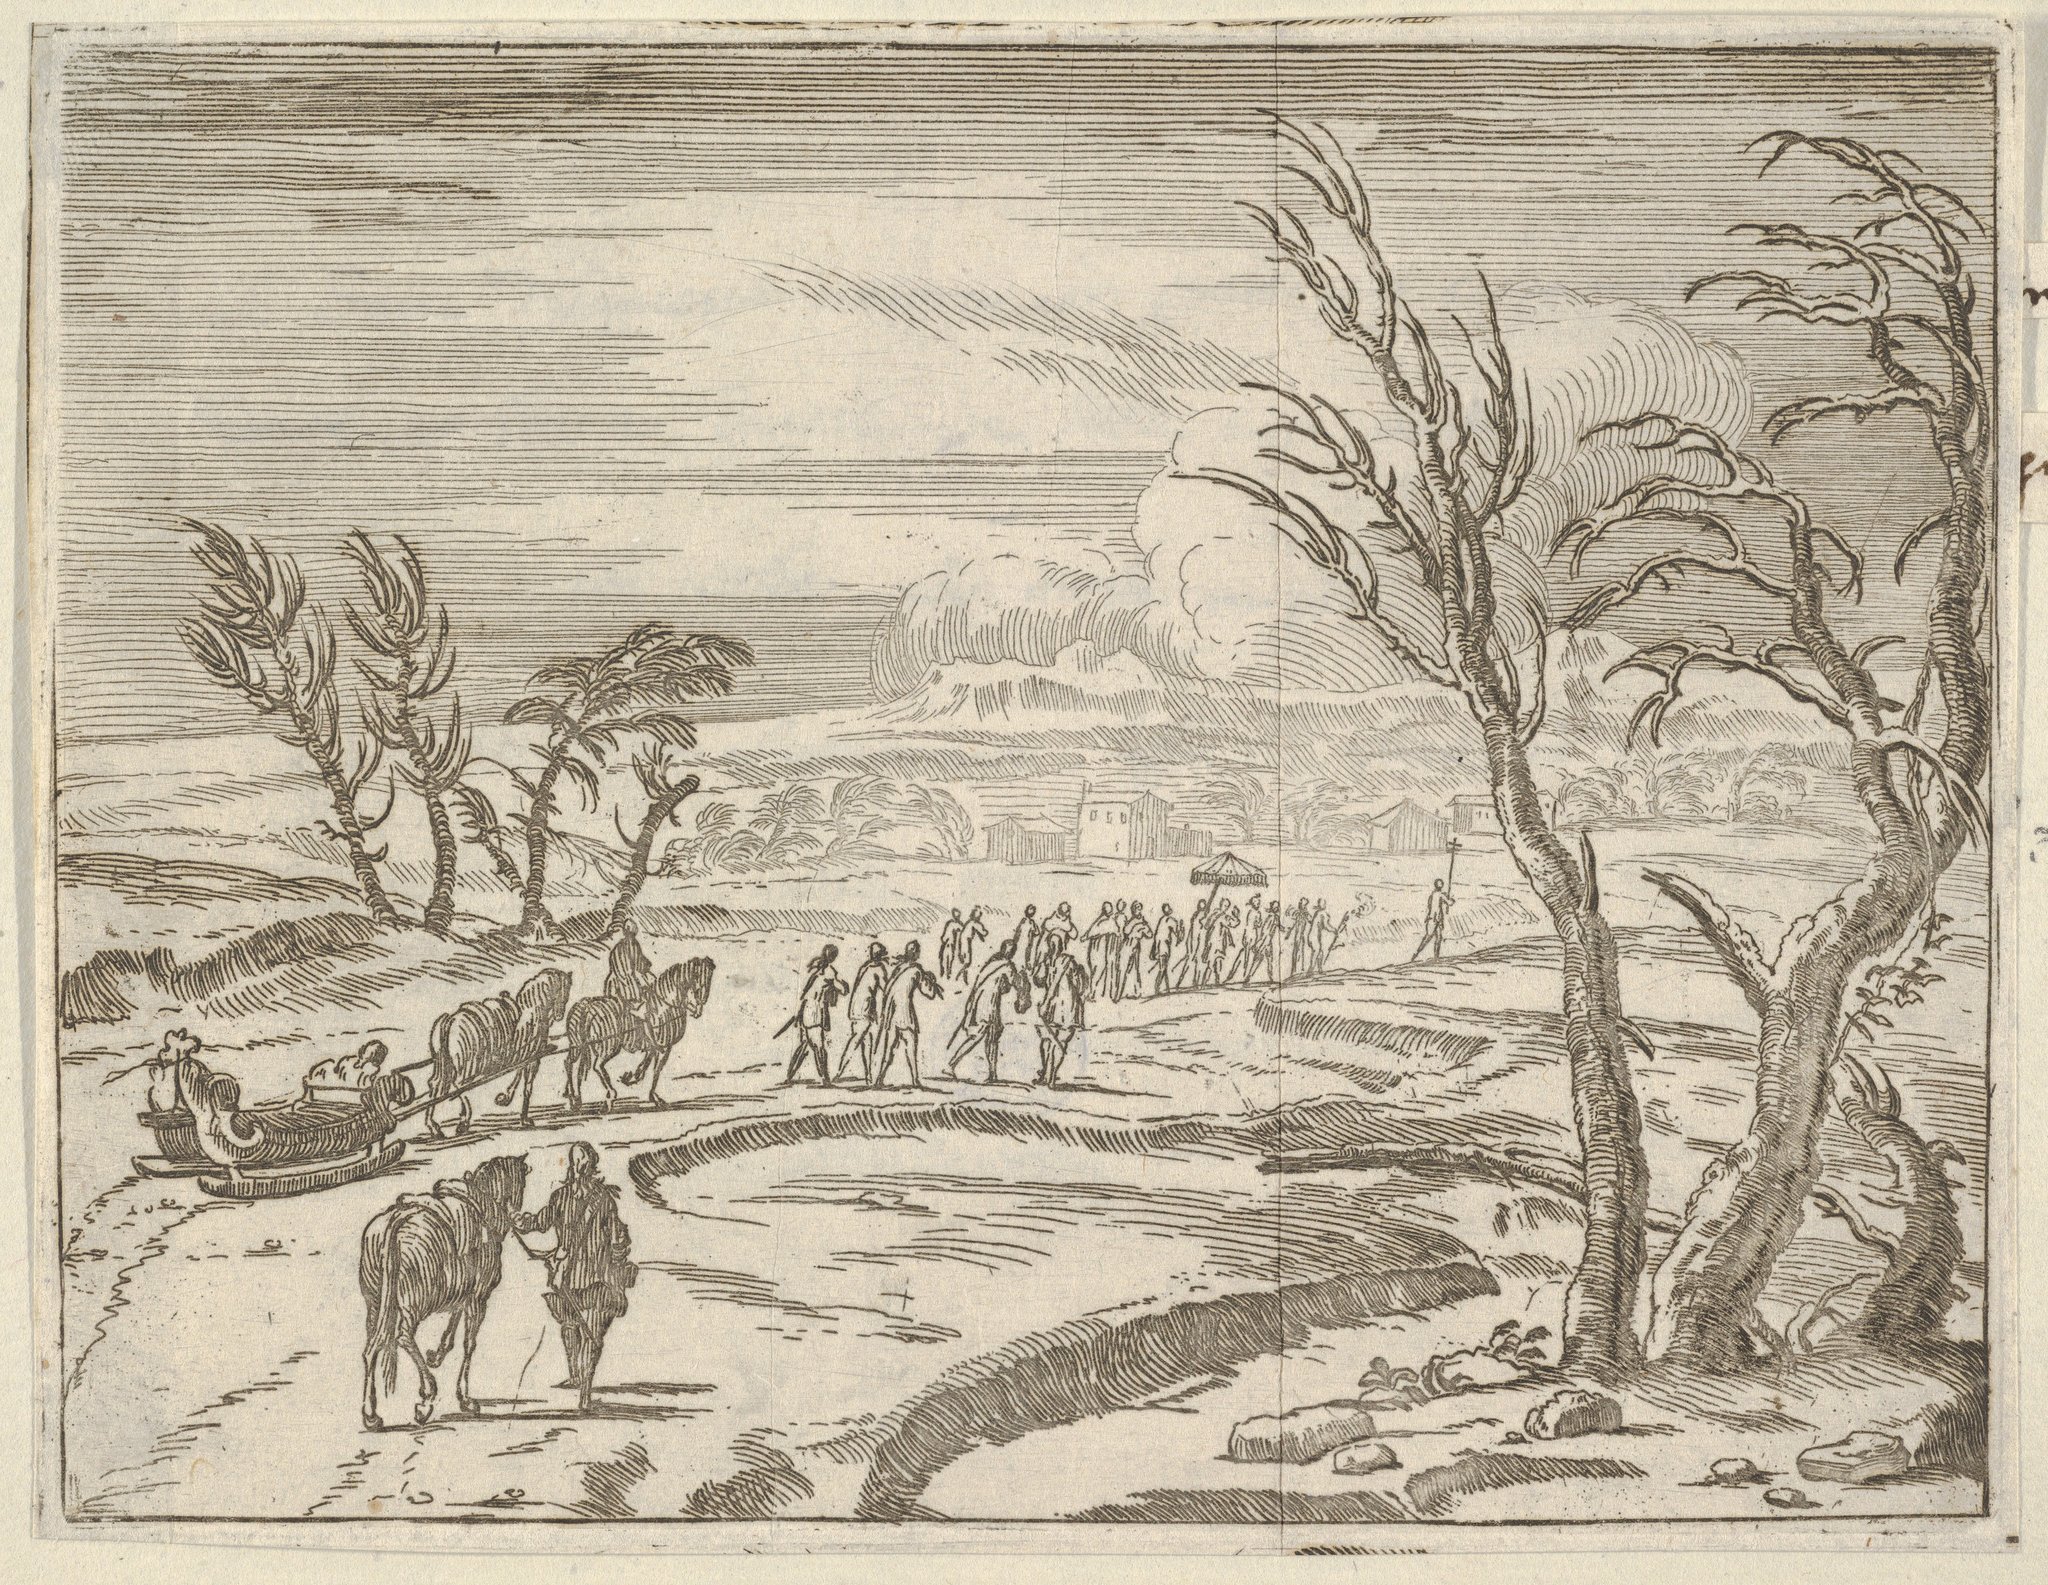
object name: print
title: Francesco I d'Este, Despite his Discomfort, Displays his Piety While Traveling in the Snow and Ice to Receive the Holy Sacrament, from "L'Idea di un Principe ed Eroe Cristiano in Francesco I d'Este, di Modena e Reggio Duca VIII [...]"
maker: bartolomeo fenice (fénis)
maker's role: artist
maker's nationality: italian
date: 1659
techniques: etching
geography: italy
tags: horses,snow,sleighs